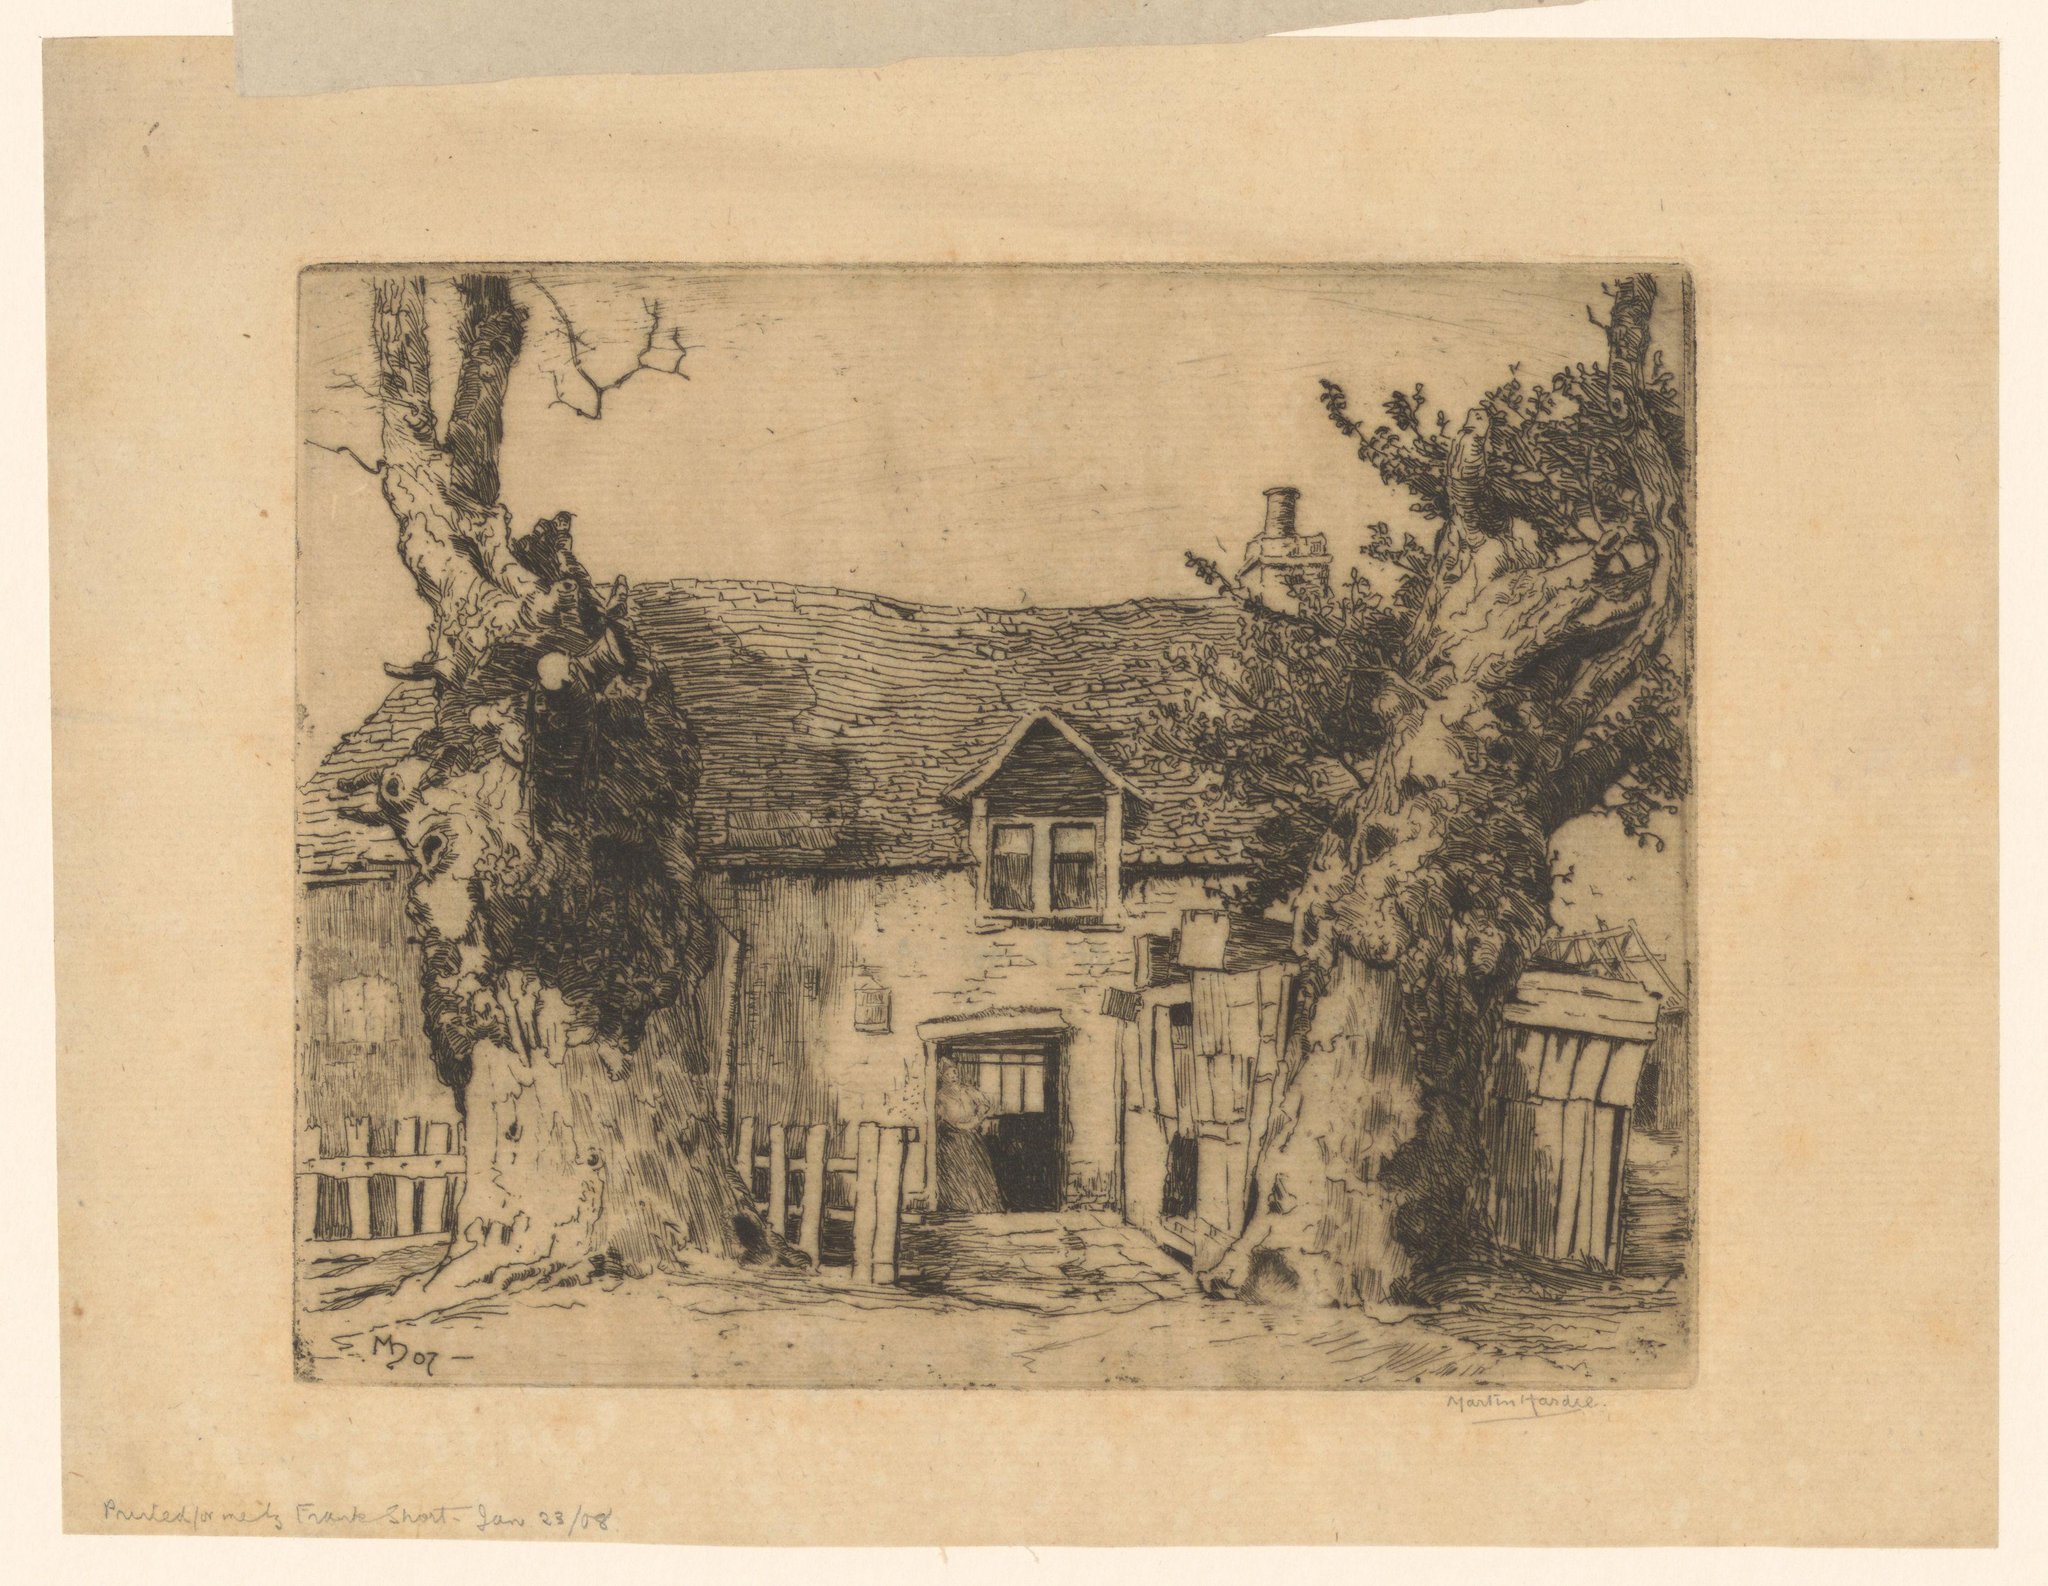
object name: print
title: Dulieu's pig farm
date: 1907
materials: paper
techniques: etching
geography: london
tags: pig, london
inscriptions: collector's mark: Lugt 2228, collector's mark: Lugt 2760, annotation: ‘Martin Hardie’